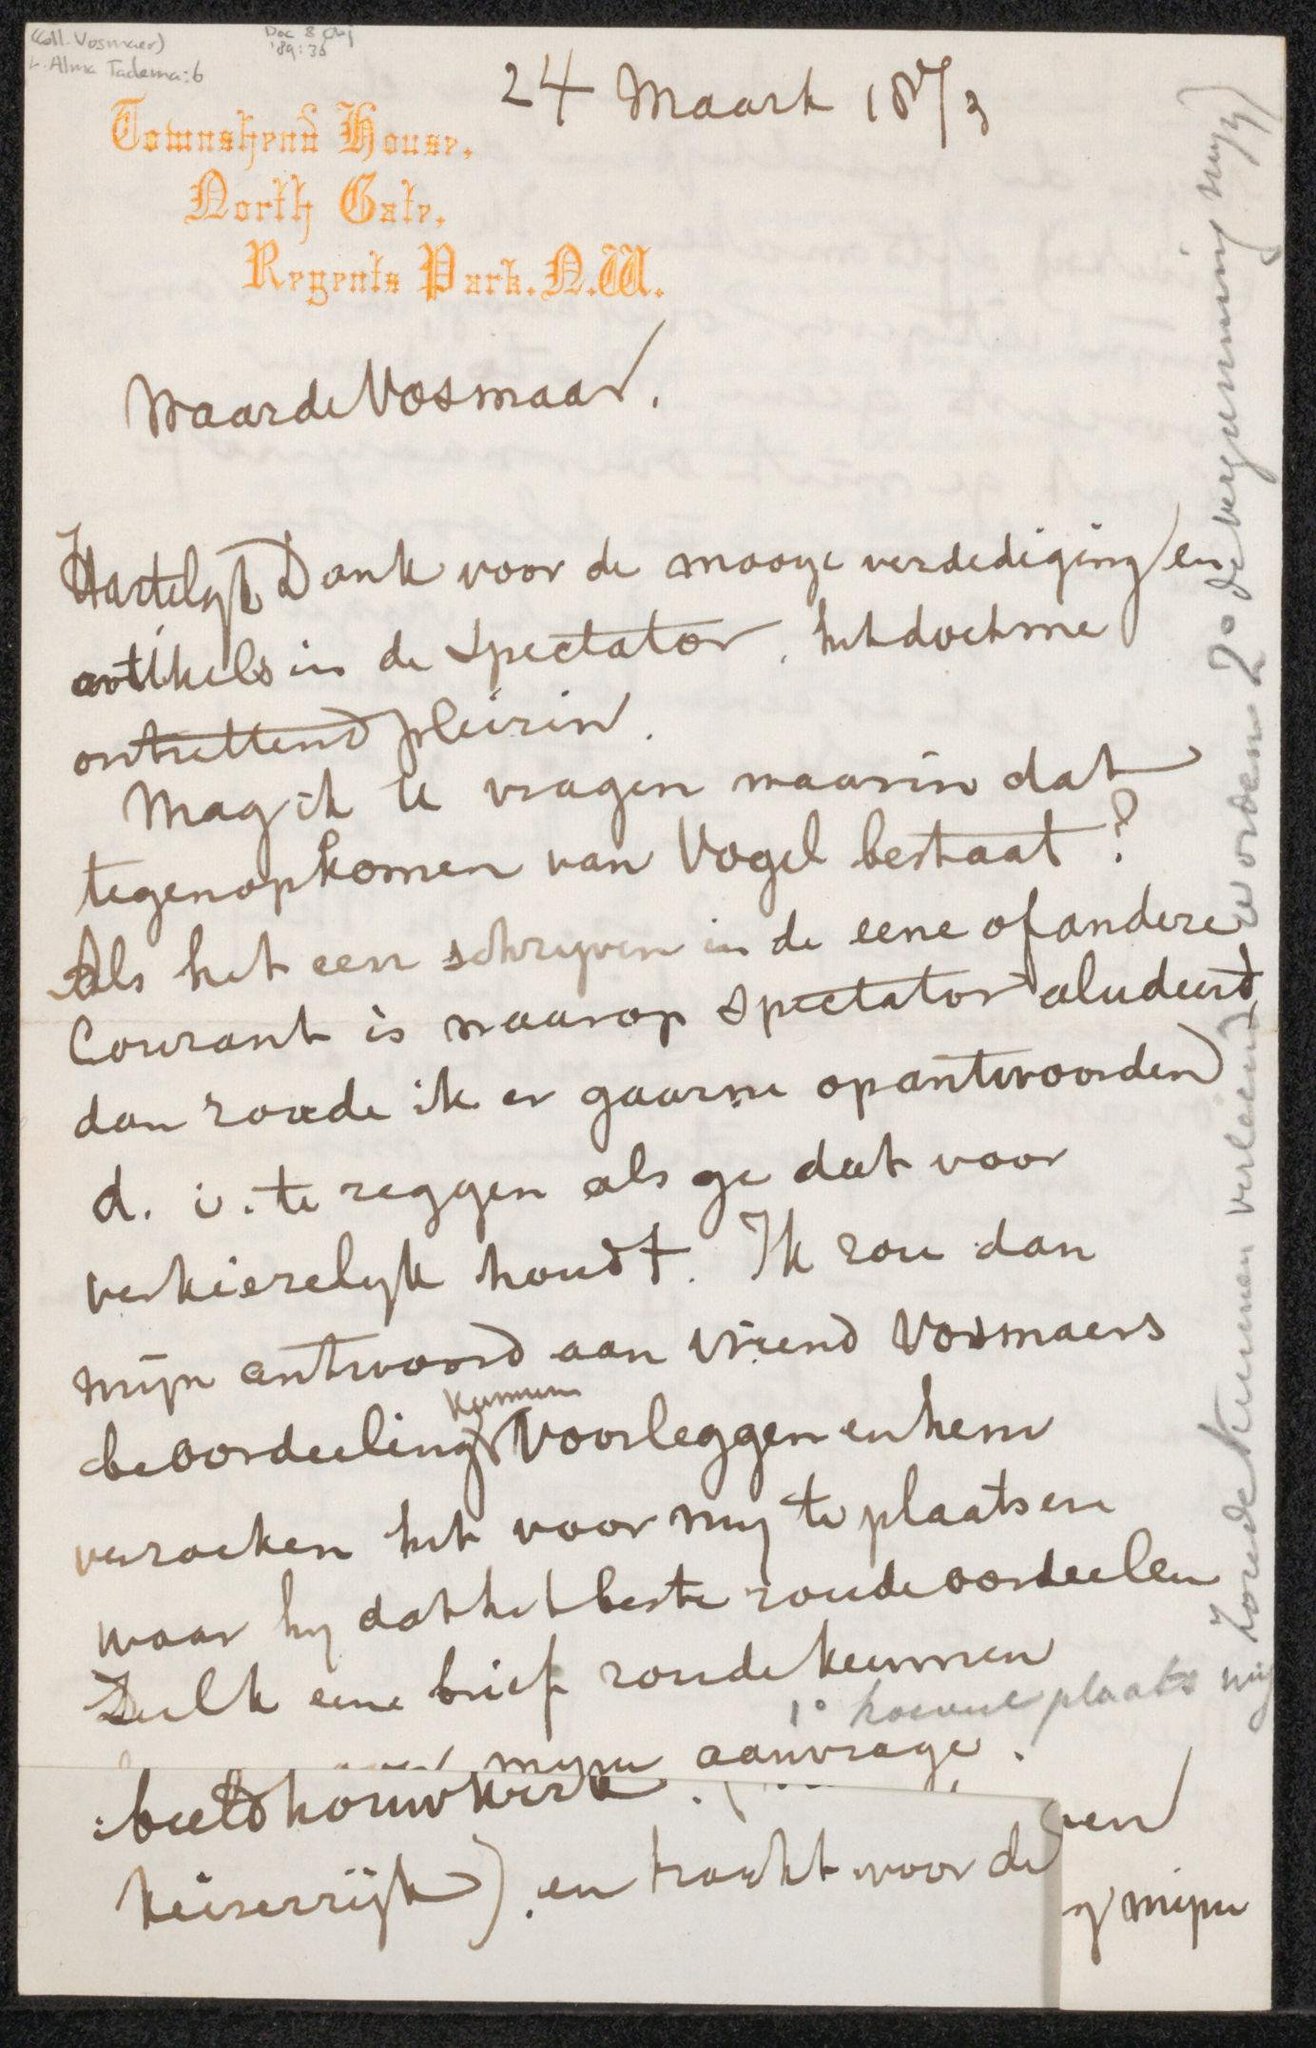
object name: letter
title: Brief aan Carel Vosmaer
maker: lourens alma tadema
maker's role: draughtsman, print maker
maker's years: 1836-1912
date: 1873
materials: ink, paper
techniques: pen, printing, writing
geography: london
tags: the hague, print maker, draughtsman, carel vosmaer, photography, cinematography, sculpture, painting (including book-illumination, miniature-painting), exhibition ~ art, vienna